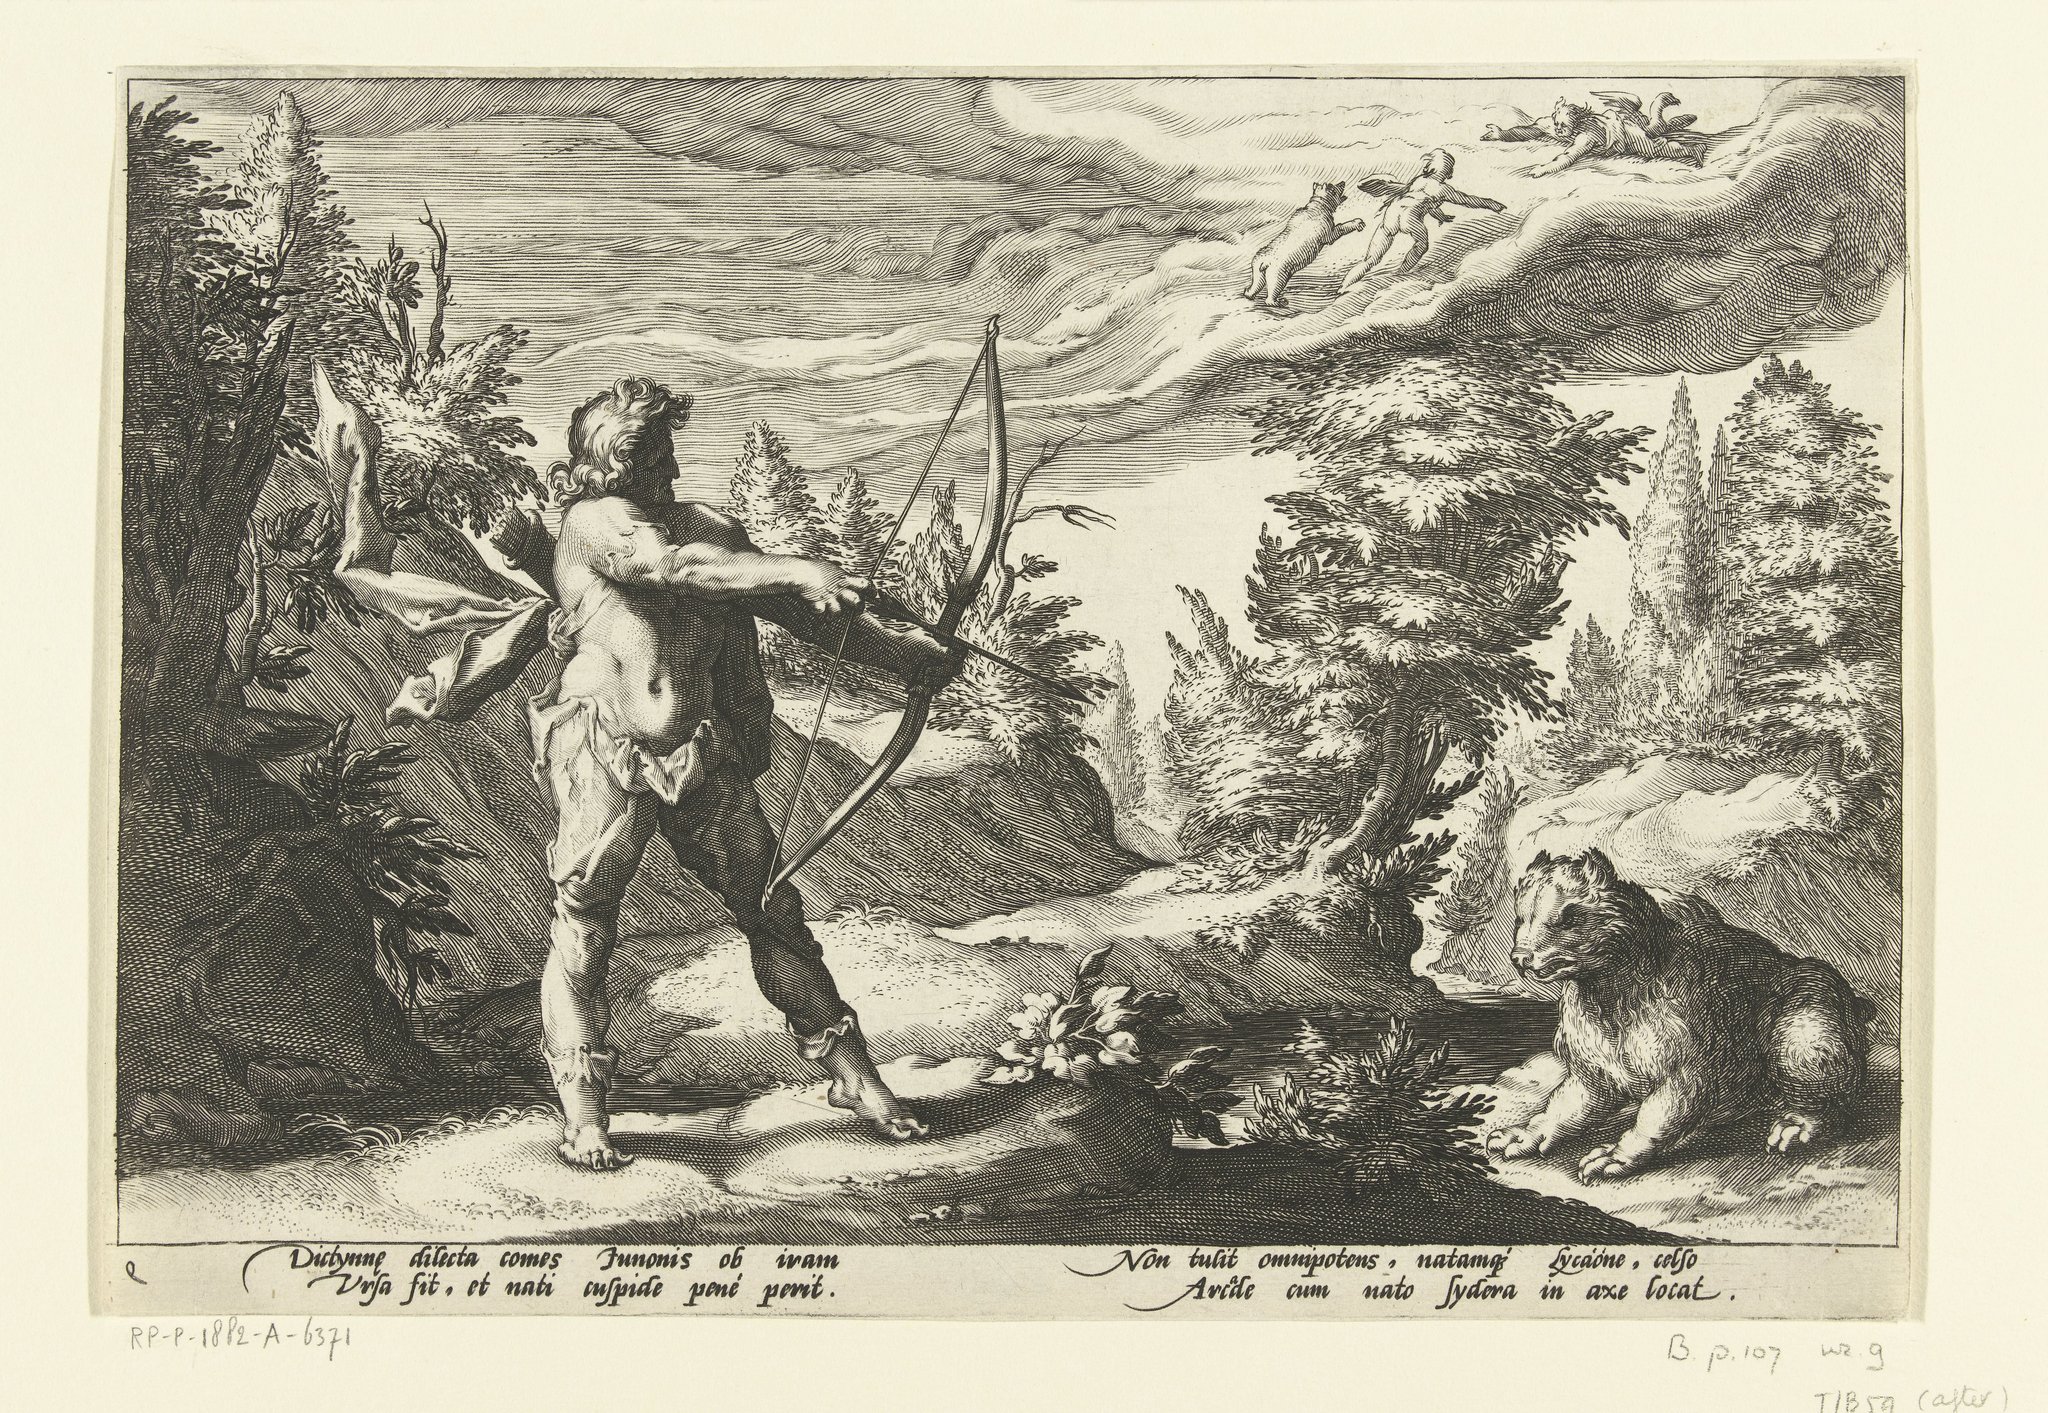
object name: print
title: Arcas richt zijn pijl op Callisto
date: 1590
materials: paper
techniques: engraving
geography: haarlem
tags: arcas changed into a constellation: when arcas is about to shoot the bear into which his mother, callisto, has been changed, jupiter turns him into a constellation (ovid, metamorphoses ii 506), callisto is hunted by her son arcas, callisto changed into a constellation: jupiter changes callisto into a constellation, when, transformed into a bear she is about to be shot by arcas (ovid, metamorphoses ii 506)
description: Arcas, de zoon van Jupiter en Callisto, richt zijn pijl op een beer, niet wetend dat dat zijn moeder is. Die is vijftien jaar eerder van gedaante veranderd. Op de achtergrond rechts is te zien hoe Jupiter moeder en zoon, voordat Arcas kan schieten, aan de hemel plaatst, als sterrenbeelden. Onder de voorstelling twee keer twee regels Latijnse tekst. Deze prent is onderdeel van een serie van 52 prenten die verhalen uit Ovidius' Metamorfosen verbeelden. Deze serie valt uiteen in drie genummerde reeksen: twee van 20 prenten en één van 12 prenten. Deze prent behoort tot de tweede reeks.